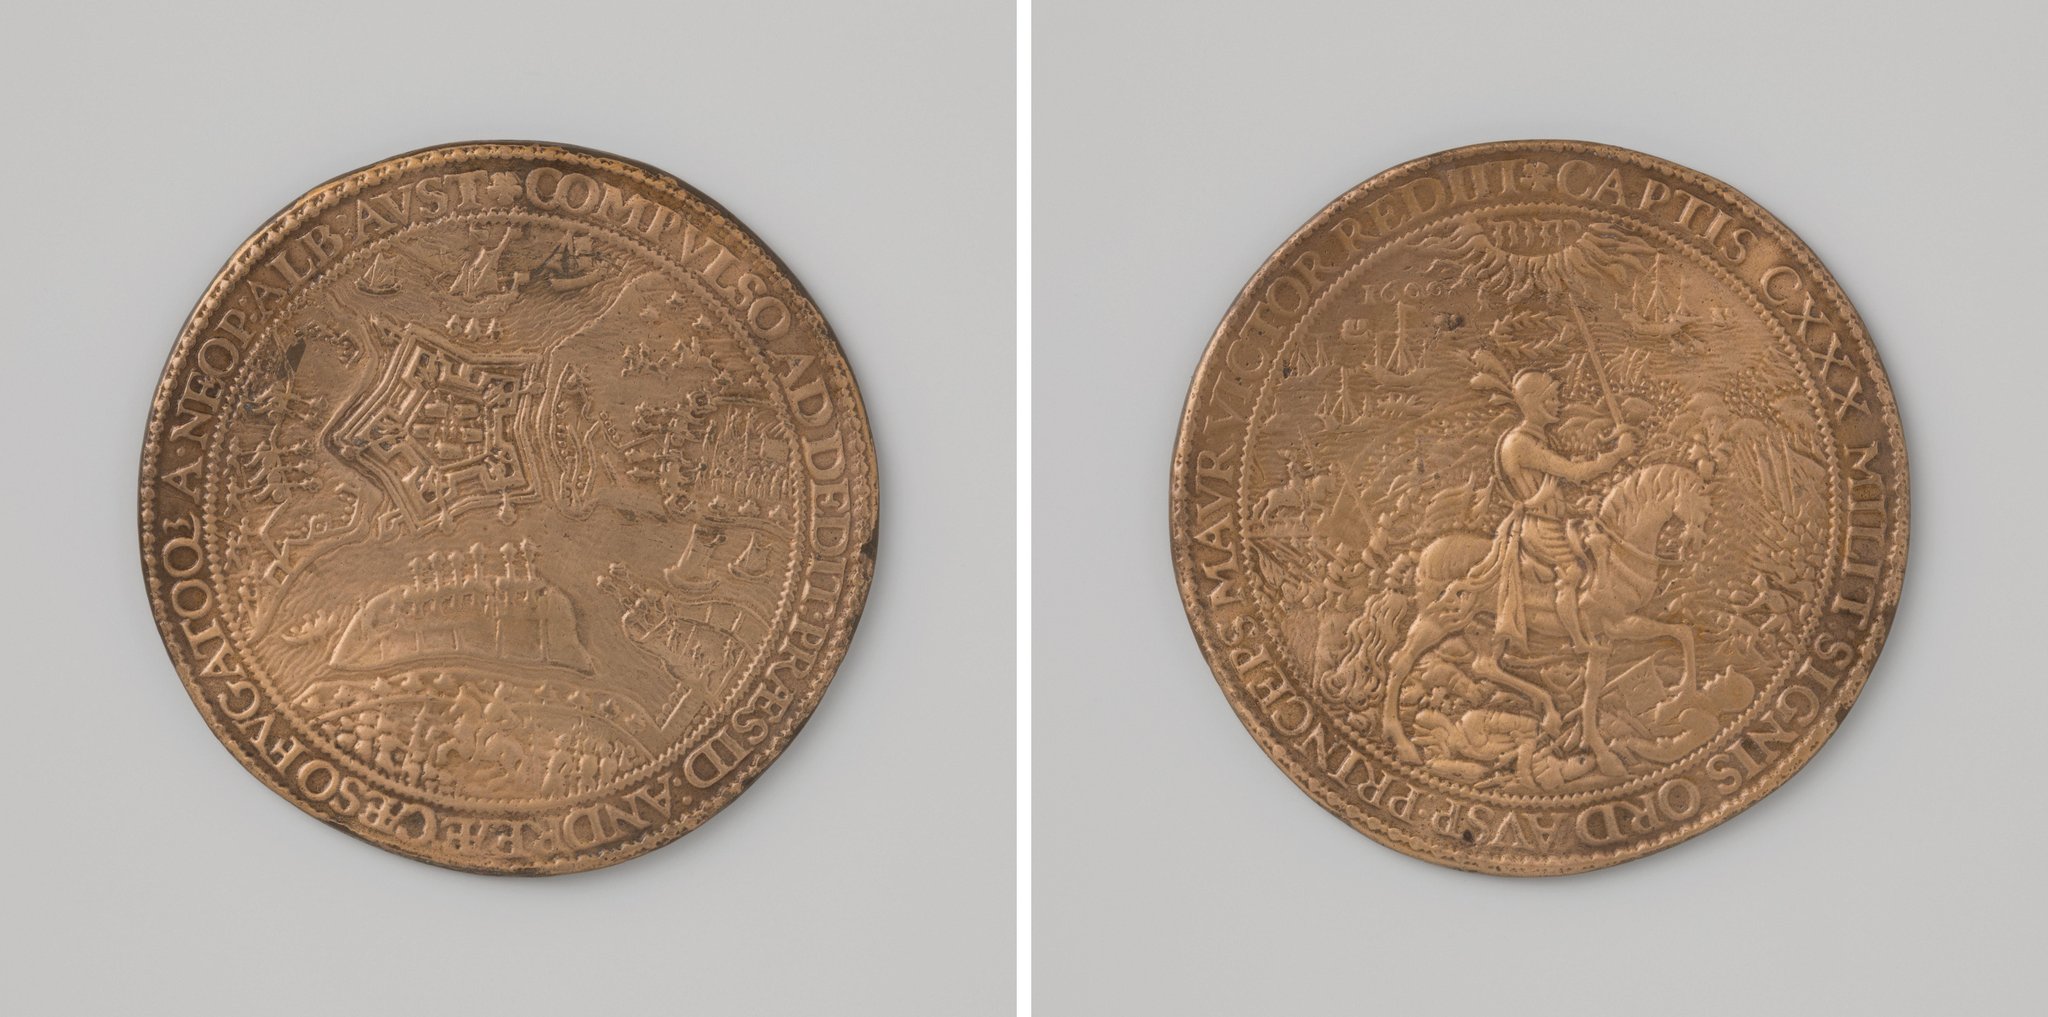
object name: history medal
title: Overwinning van Prins Maurits op Spanje in de Slag bij Nieuwpoort 1600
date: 1600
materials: tin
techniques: casting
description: Verbronst tinnen penning, op de voorzijde de plattegrond van het strijdtoneel rond de schans Sint Andries, met omschrift, op de keerzijde Prins Maurits geharnast te paard tijdens de slag, met omschrift.